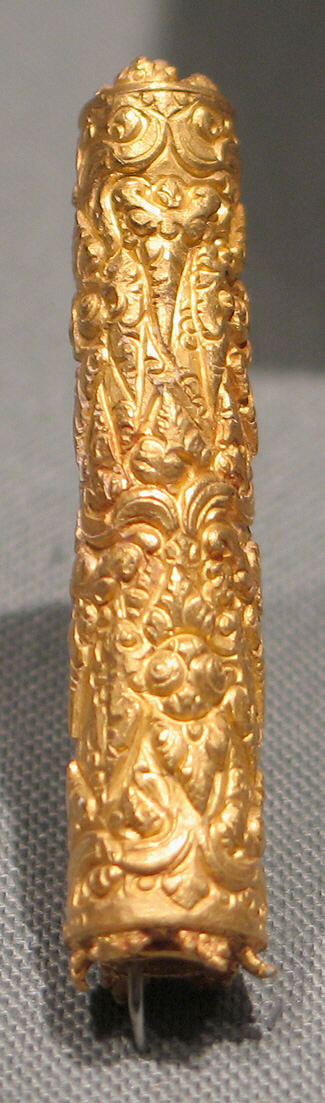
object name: hairpin top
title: Top of a Hairpin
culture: indonesian, javanese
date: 801-1400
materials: gold